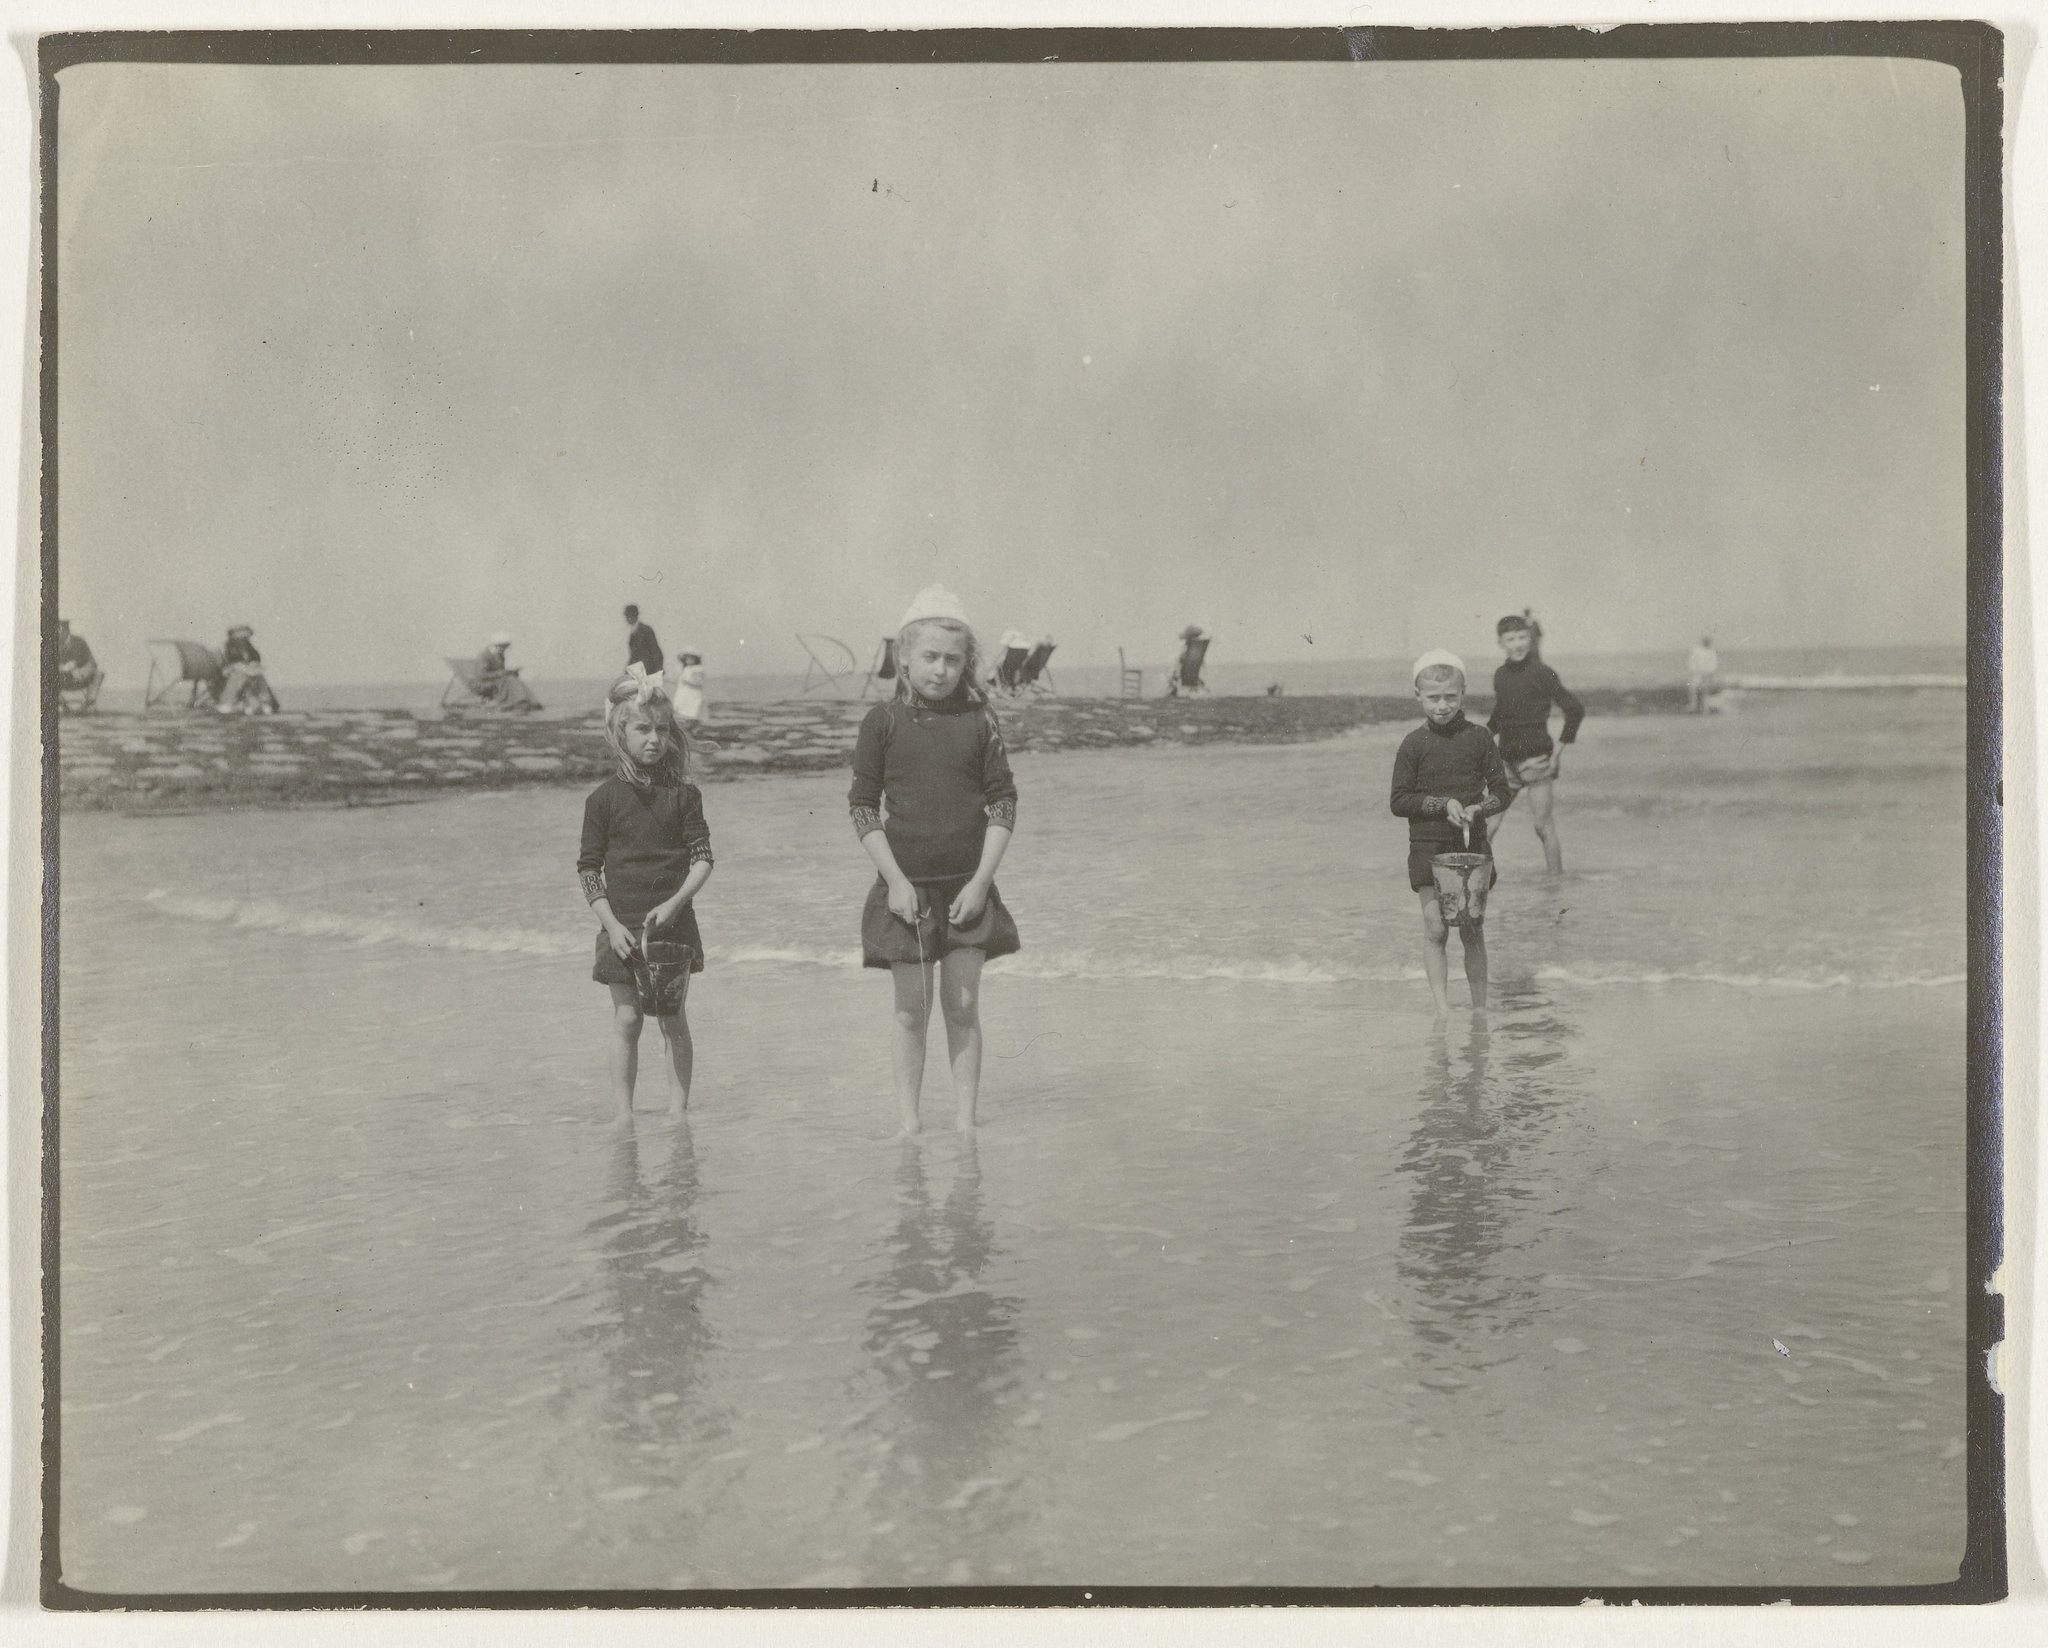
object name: photograph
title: Kinderen in zee (Noordzeekust), Nederland of Duitsland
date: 1900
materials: paper, photographic support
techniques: gelatin silver print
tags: beach (as place of recreation), netherlands, germany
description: Kinderen in zee (Noordzeekust), Nederland of Duitsland, met op de achtergrond een dam waar mensen zitten.